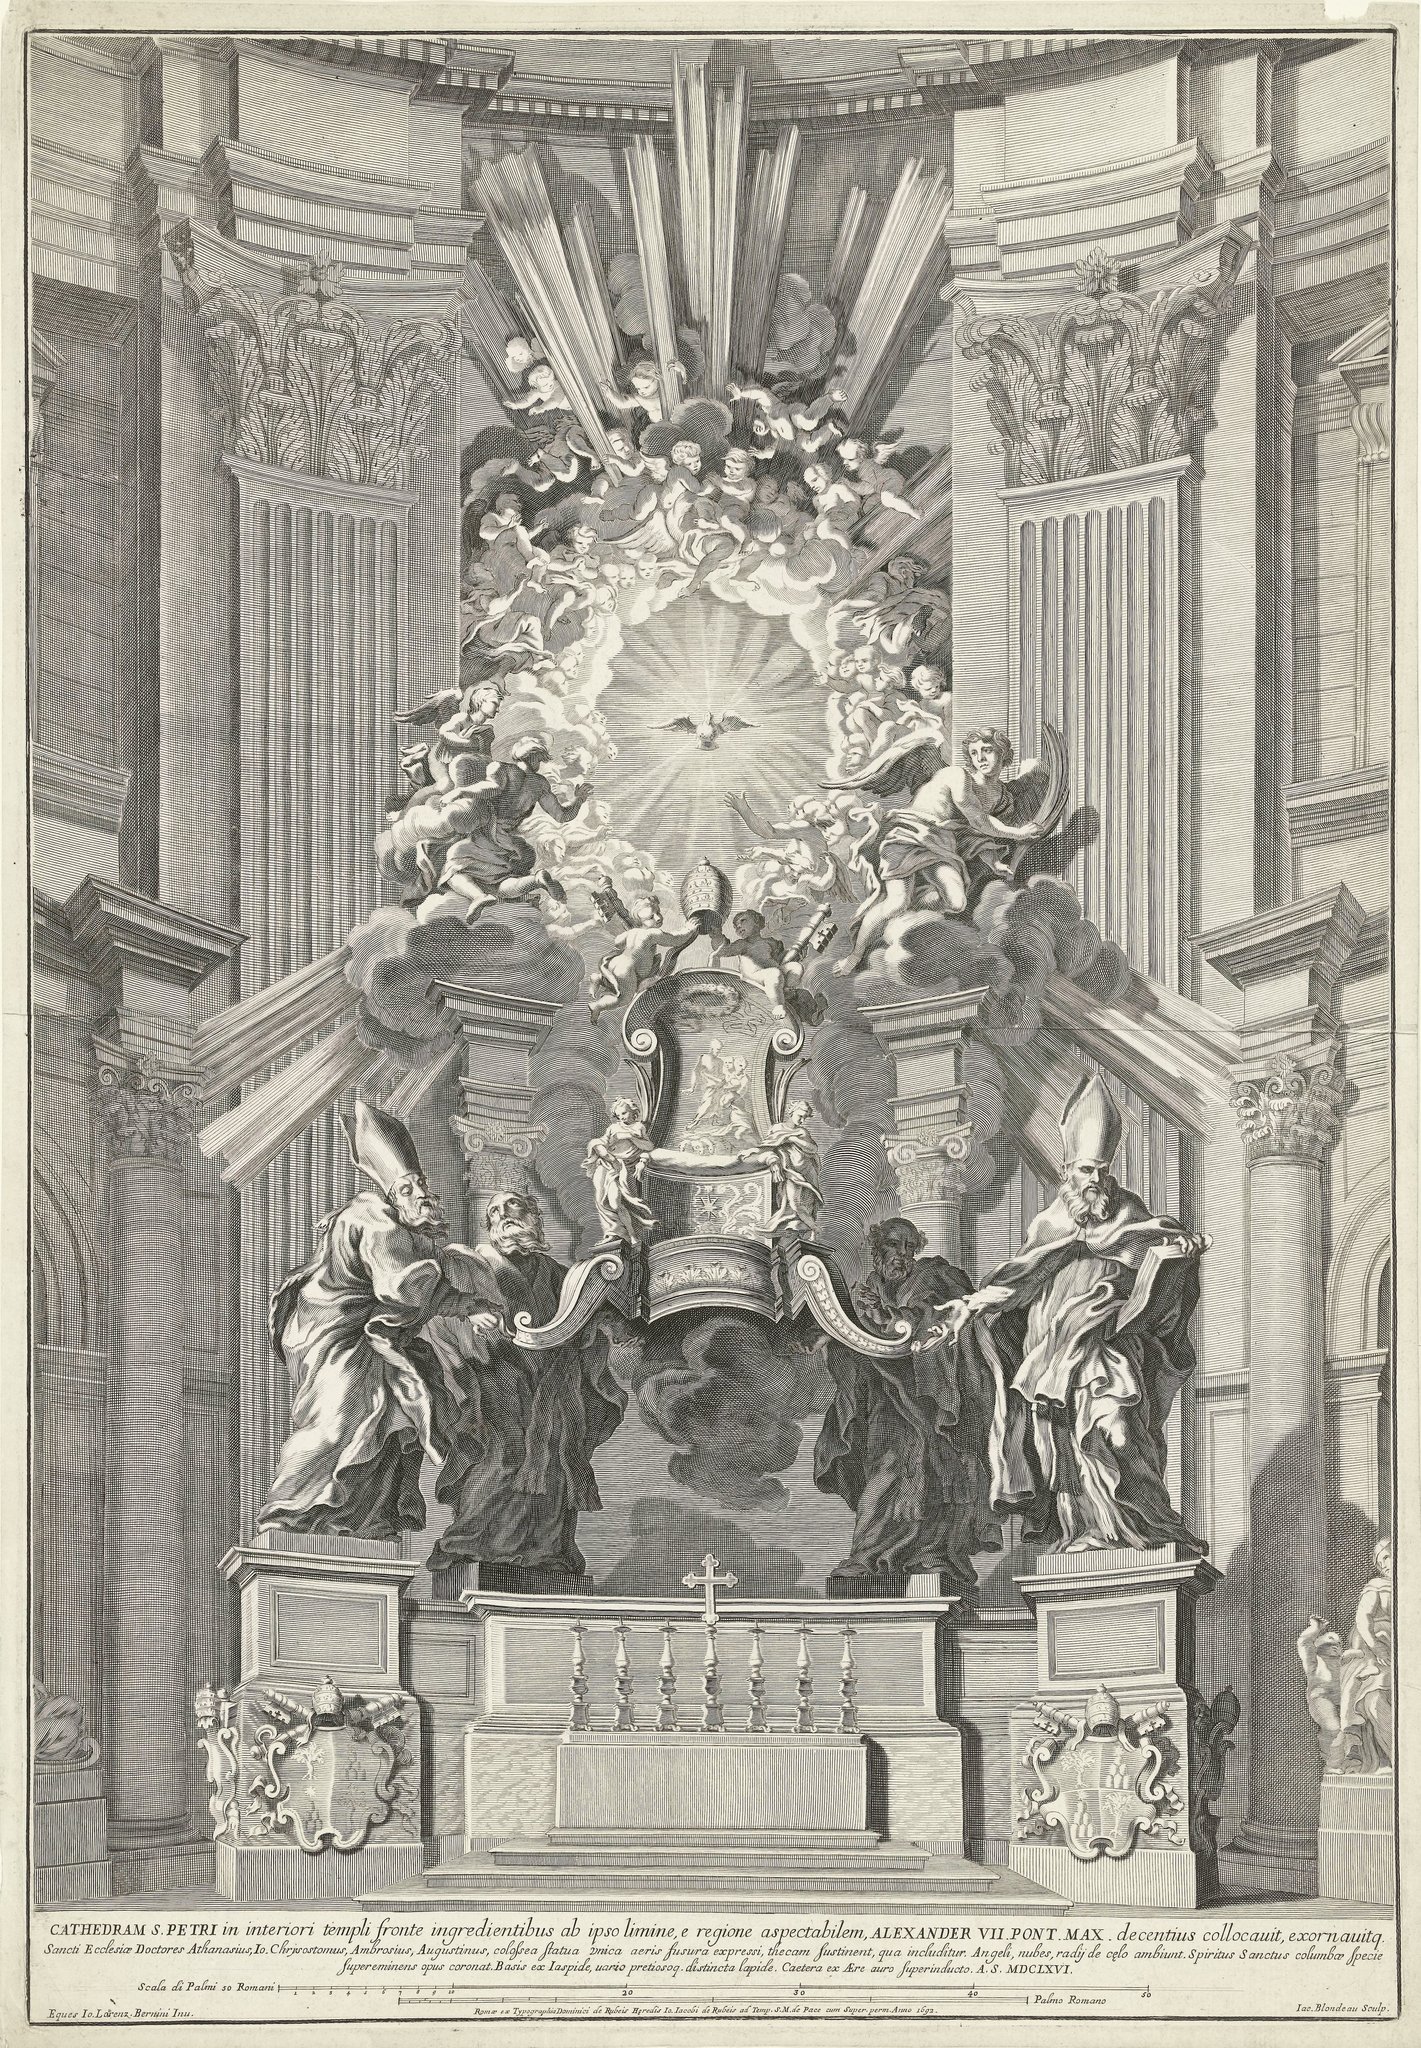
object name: print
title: Cathedram S. Petri in (...) Aere auro superinducto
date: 1692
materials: paper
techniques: engraving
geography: rome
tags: throne of st. peter, the four latin (western) fathers of the church together: ambrose (usually as bishop), jerome (usually as cardinal), augustine (usually as bishop), gregory the great (usually as pope)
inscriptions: collector's mark: Lugt 240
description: Prent naar beeld van Giovanni Lorenzo Bernini in de Sint Pieter te Rome